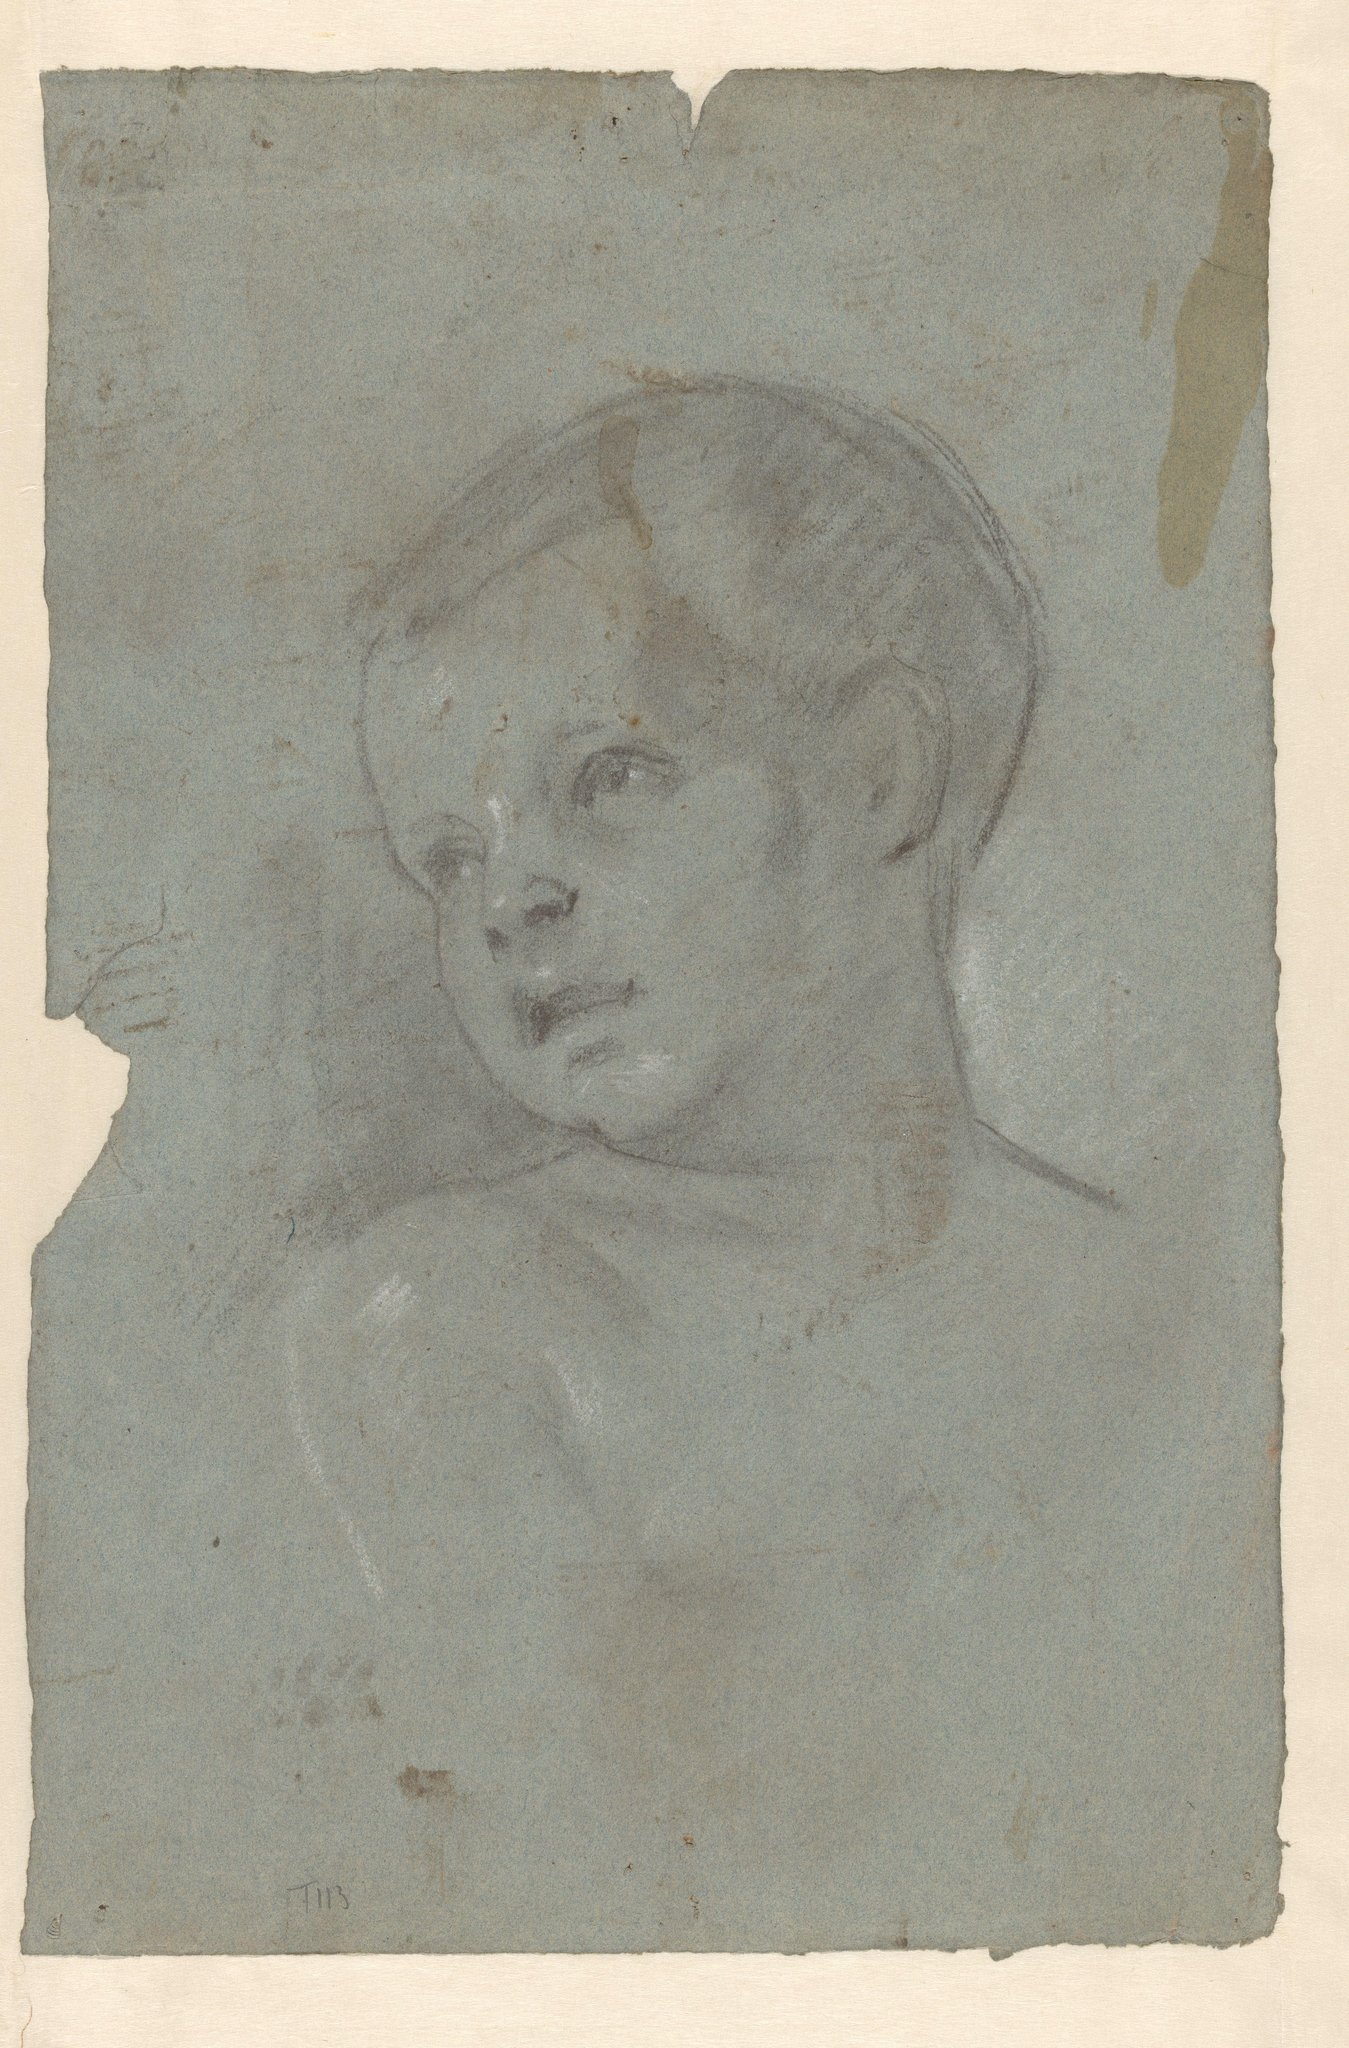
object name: drawing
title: Portret van een onbekend kind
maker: willem witsen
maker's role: draughtsman, painter, print maker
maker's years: 1860-1923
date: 1870-1923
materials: chalk, paper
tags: child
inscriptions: number: ‘T113’